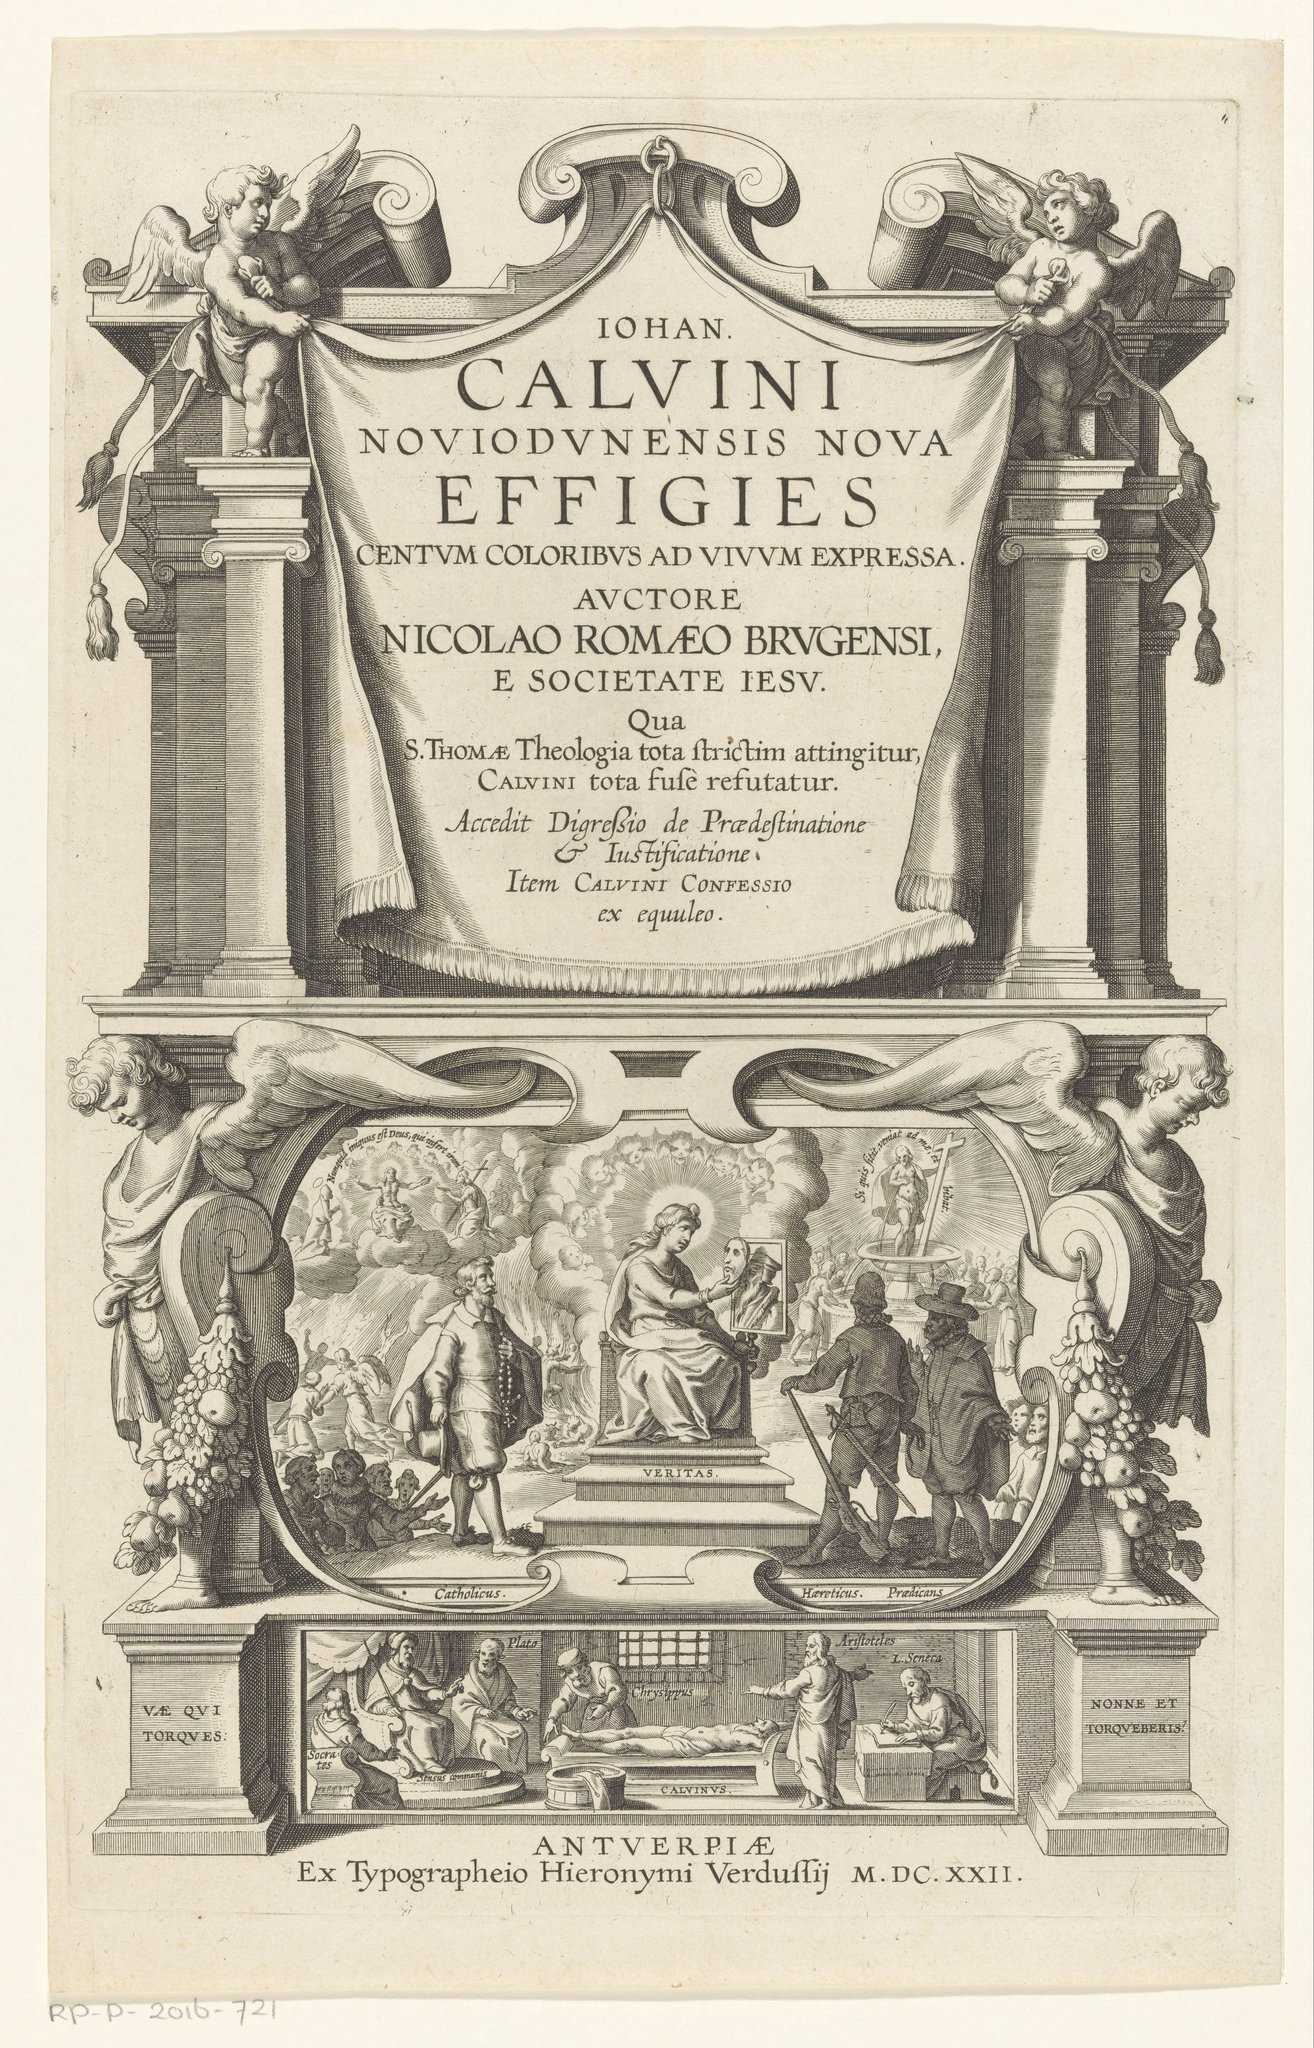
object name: print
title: Allegorische voorstelling met Waarheid, een katholiek, een ketter en een predikant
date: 1622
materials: paper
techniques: engraving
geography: antwerp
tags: heretic, representants of the church (christians in general, laymen, monks, etc.) in strife with each other or with opponents, truth; 'verità' (ripa)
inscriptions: collector's mark: Lugt 2228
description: Waarheid zit op een troon en houdt een masker voor een portret van Calvijn. Bij haar staan een katholiek, een ketter en een predikant. Links in de achtergrond het Laatste Oordeel, rechts Christus als fontein des levens. Aan de onderzijde een scène met een liggende Calvijn te midden van filosofen zoals Plato en Aristoteles. Aan de bovenzijde houden twee putti een doek met de titel vast.